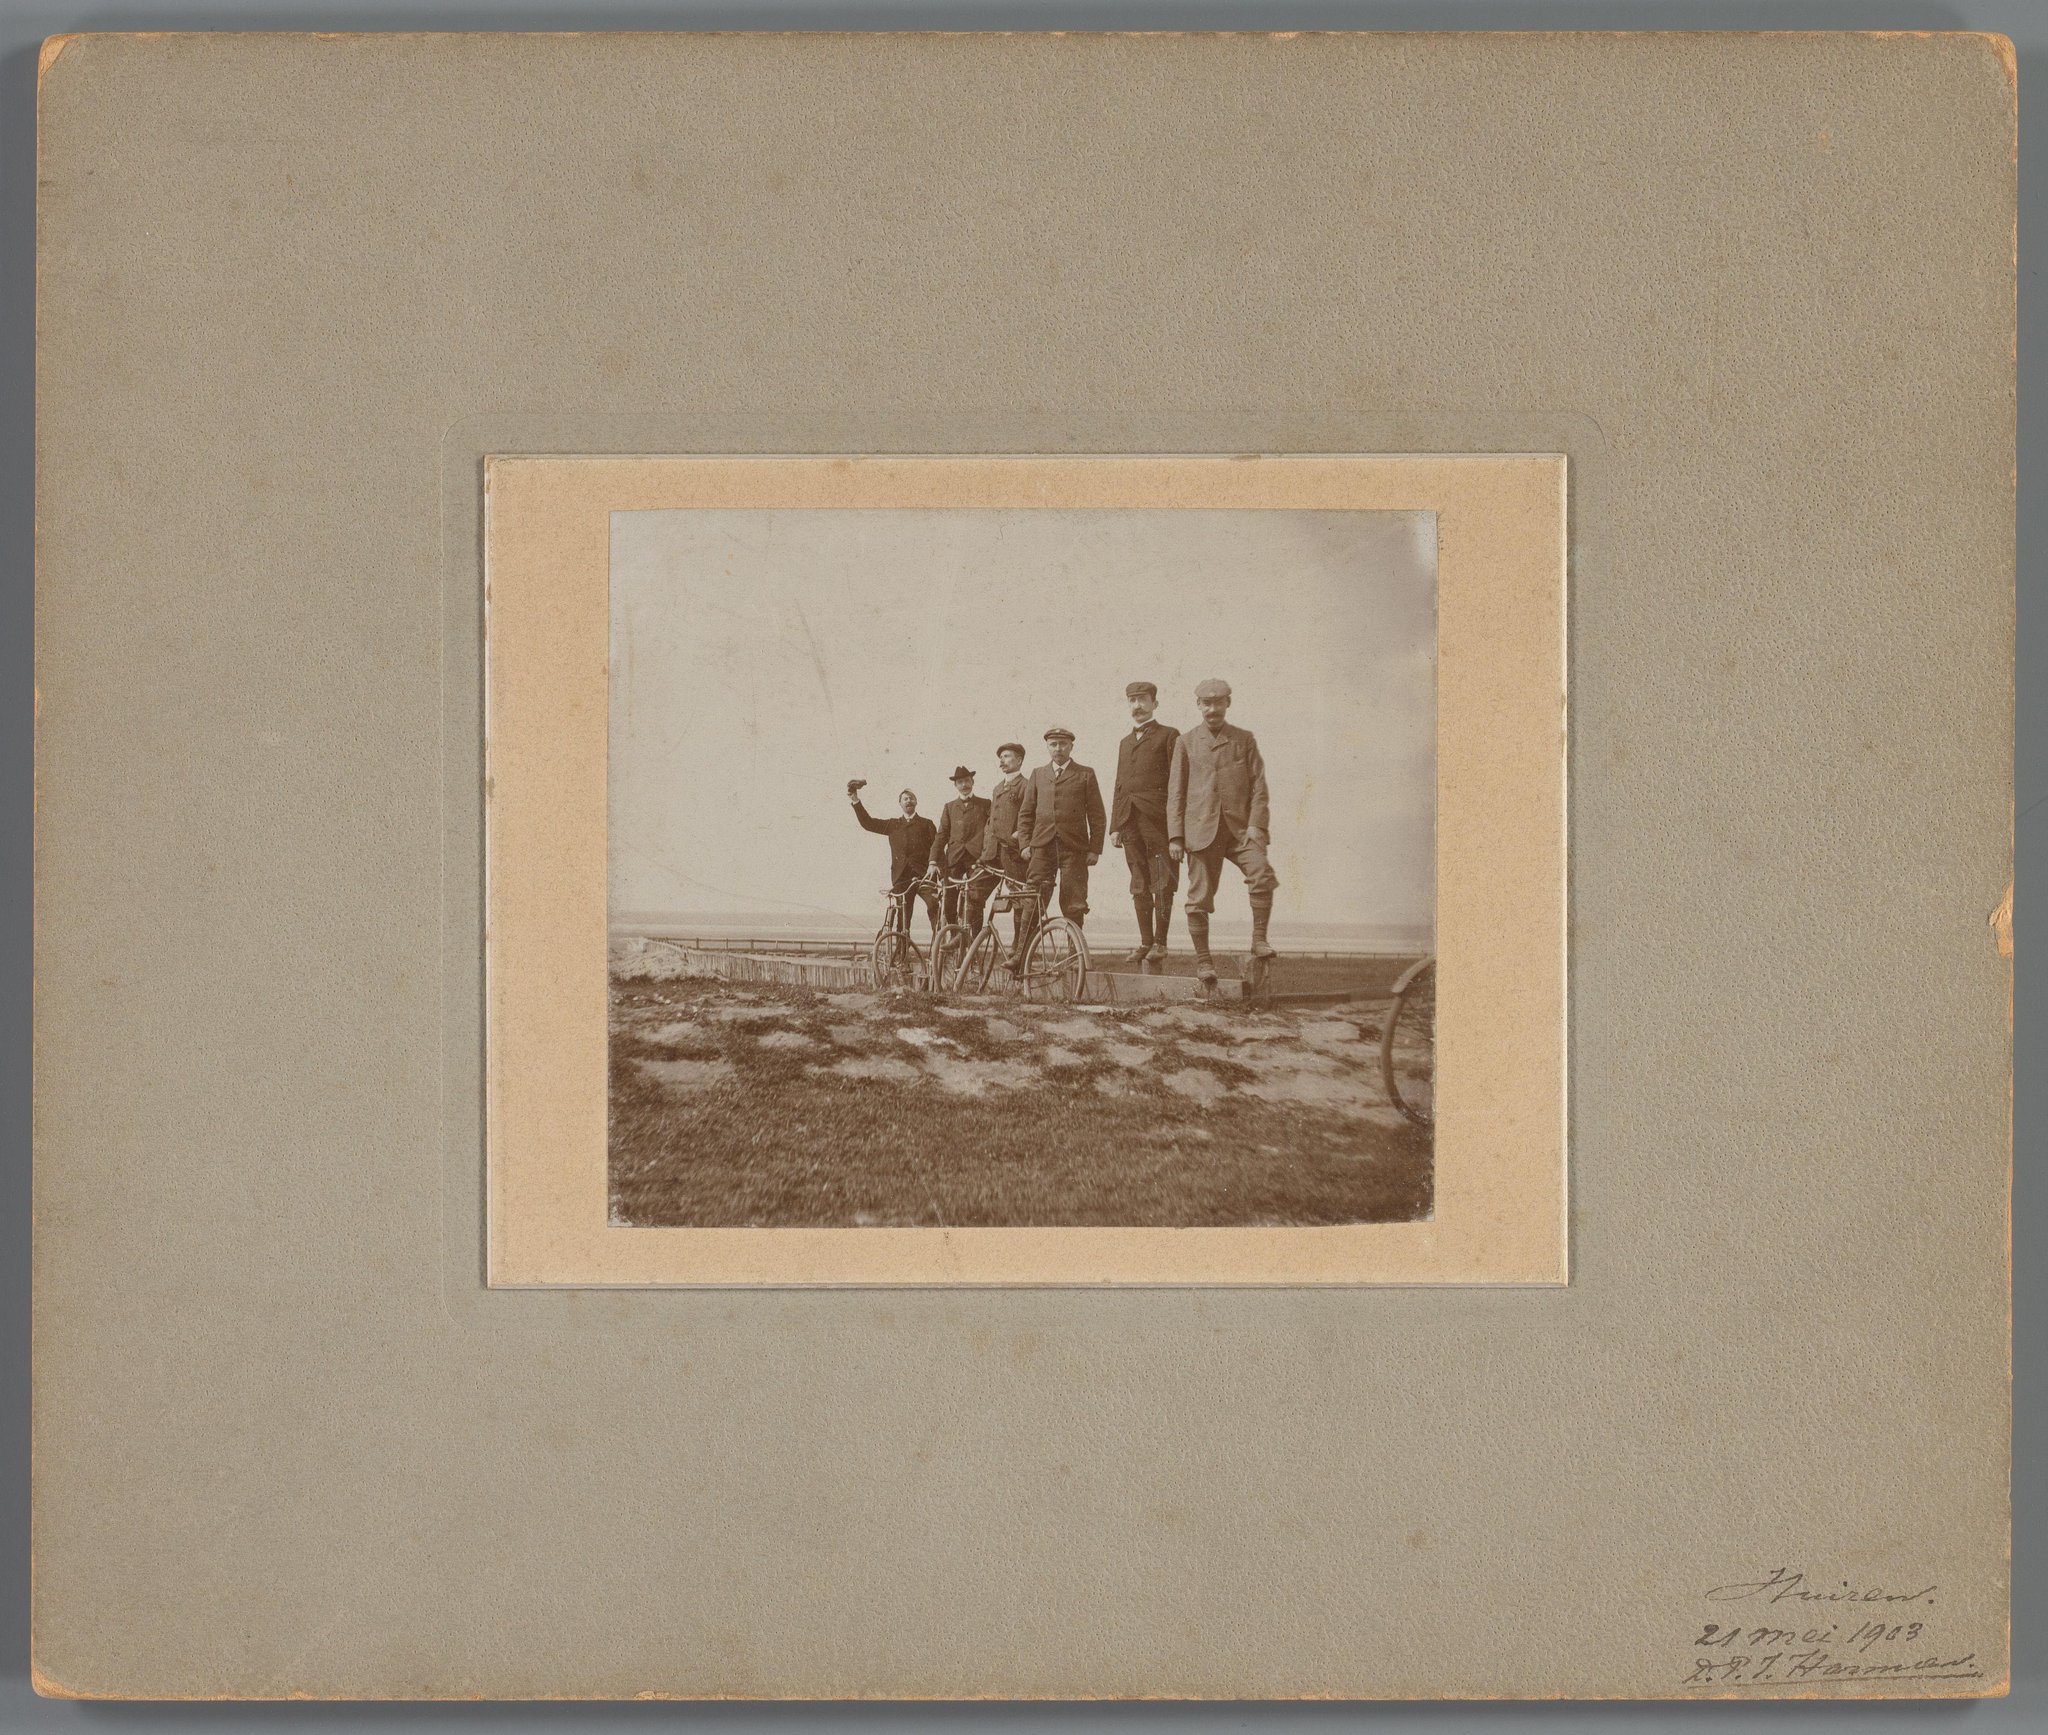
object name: photograph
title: Groepsportret van François Buys en vijf vrienden, poserend met fietsen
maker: d.p.j. harmsen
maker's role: fotograaf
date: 1903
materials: paper, cardboard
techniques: gelatin silver print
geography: huizen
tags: amsterdam, françois buys, bicycle, anonymous historical persons portrayed in a group, in a group-portrait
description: Deze foto maakt deel uit van een groep van 38 foto's.